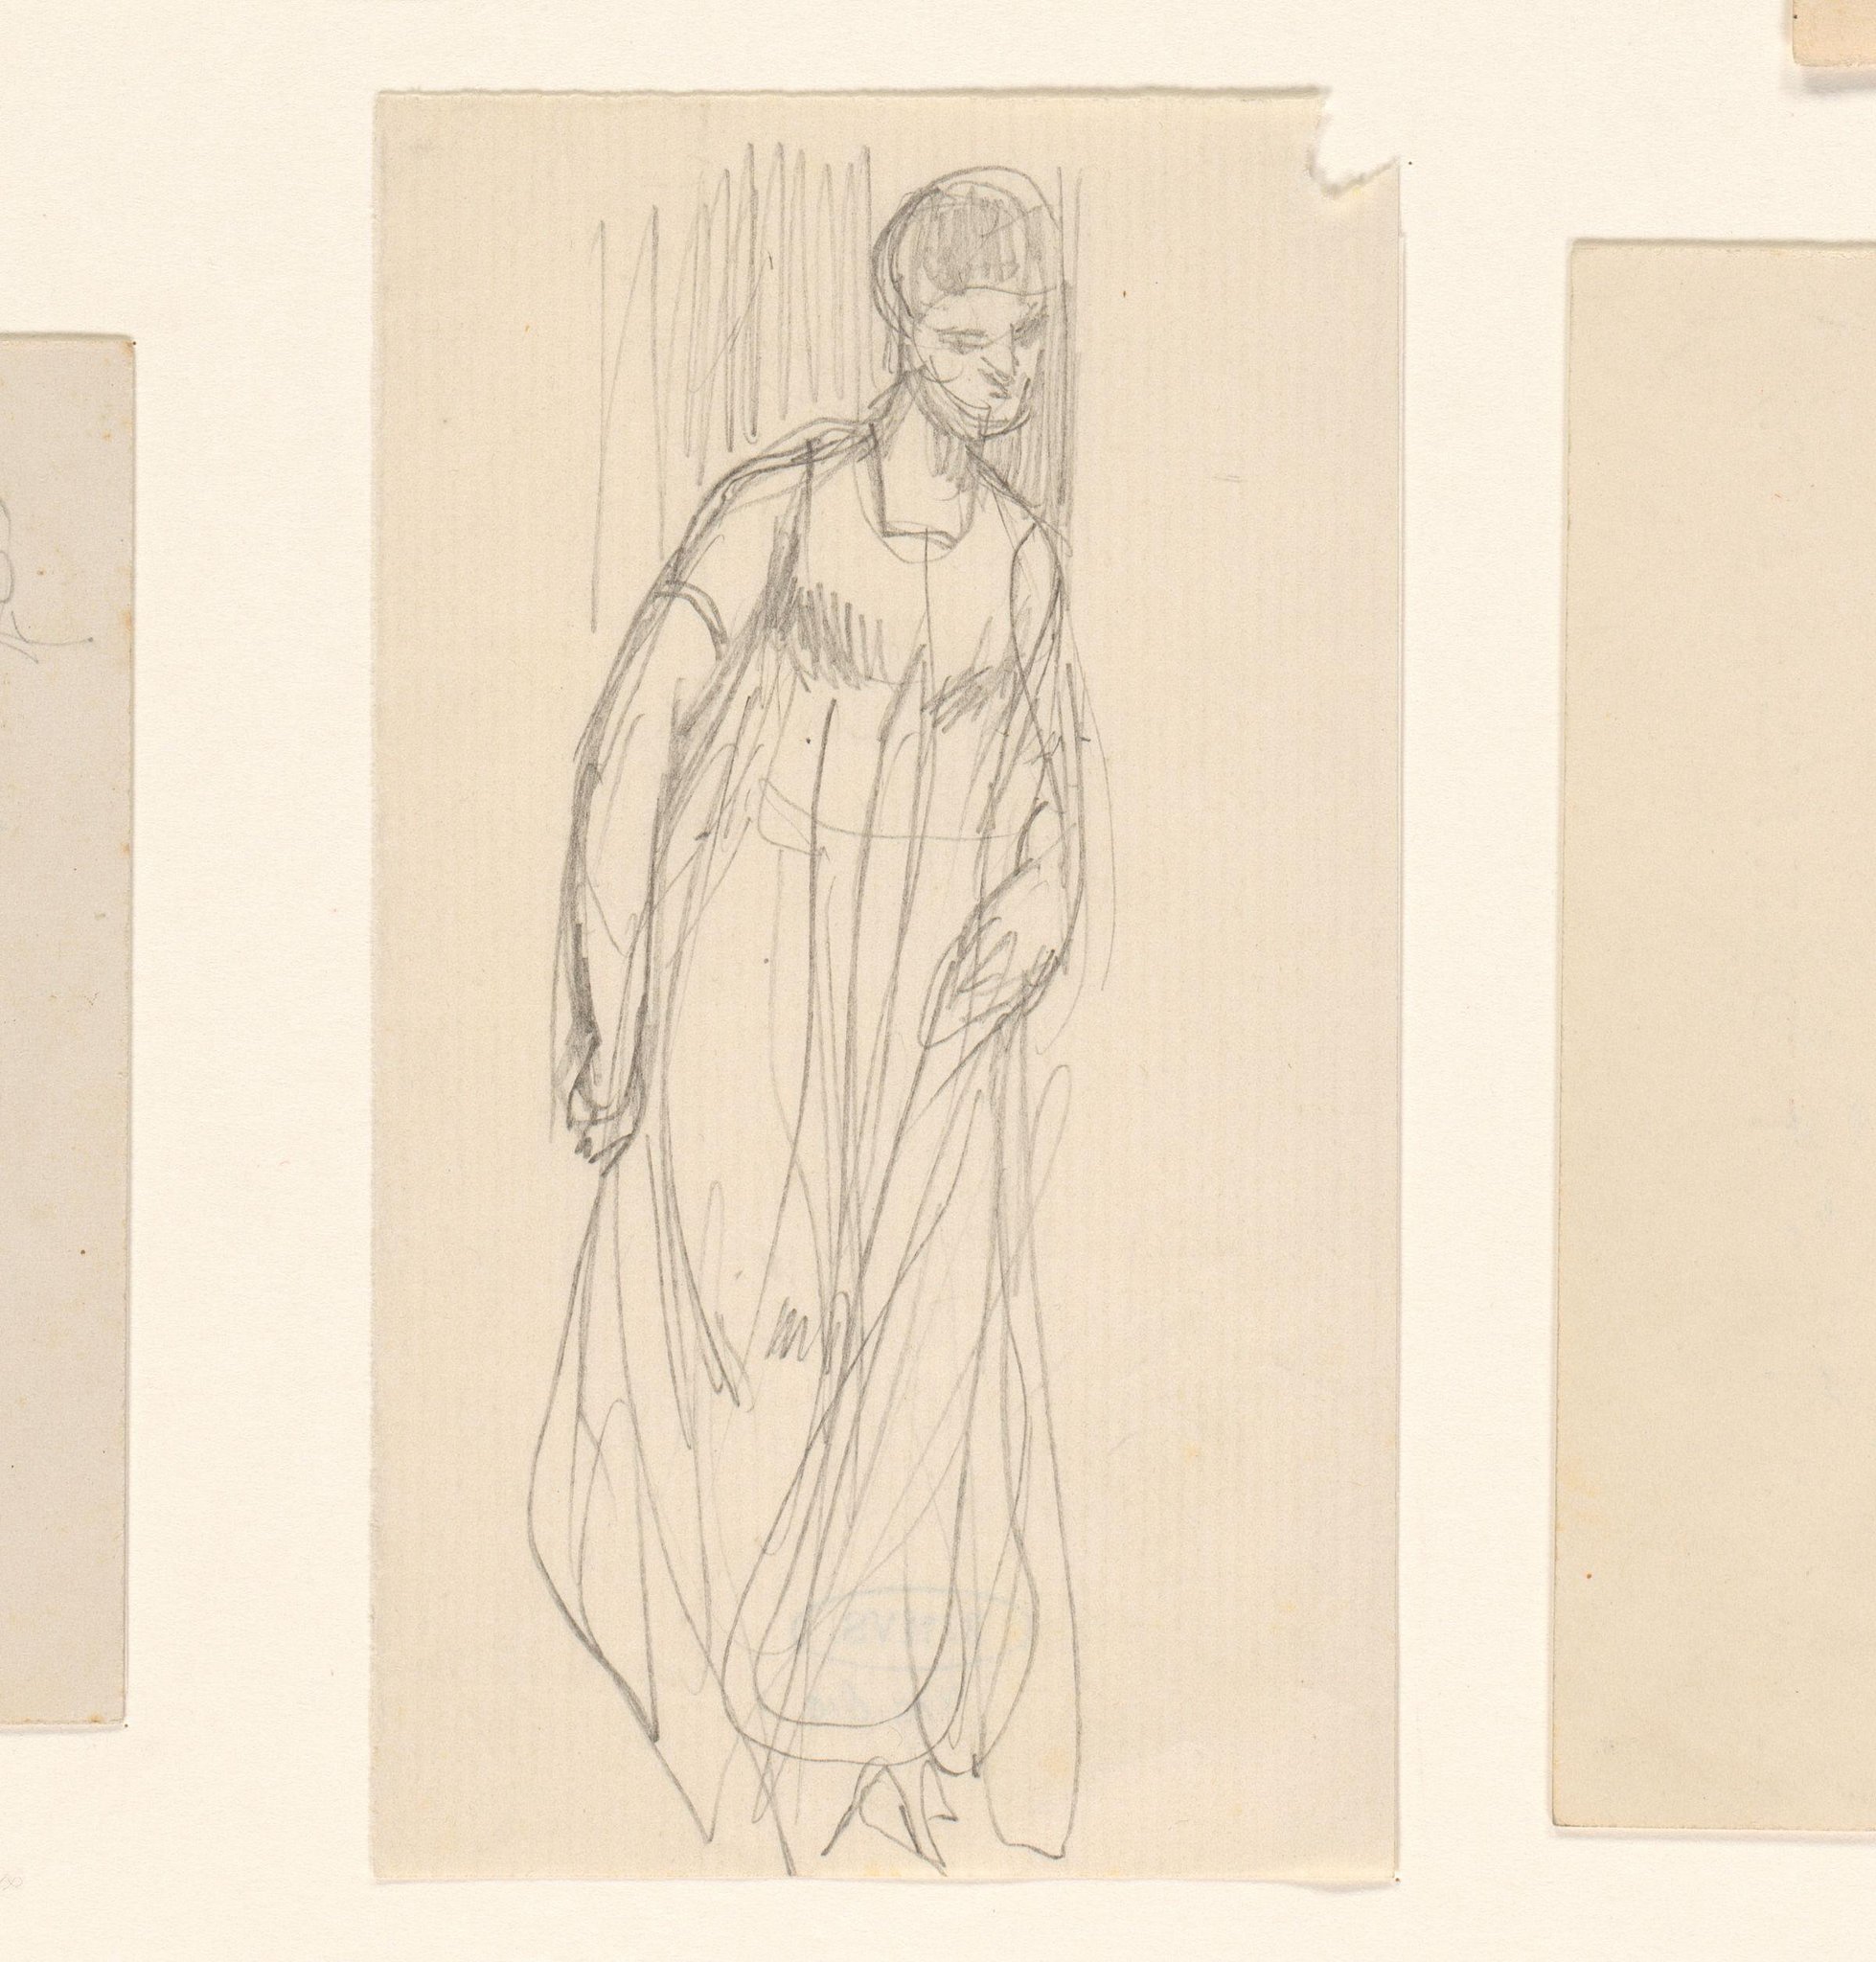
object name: drawing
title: Studie van een staande vrouw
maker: august allebé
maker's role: draughtsman, print maker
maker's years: 1838-1927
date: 1848-1927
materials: paper, pencil